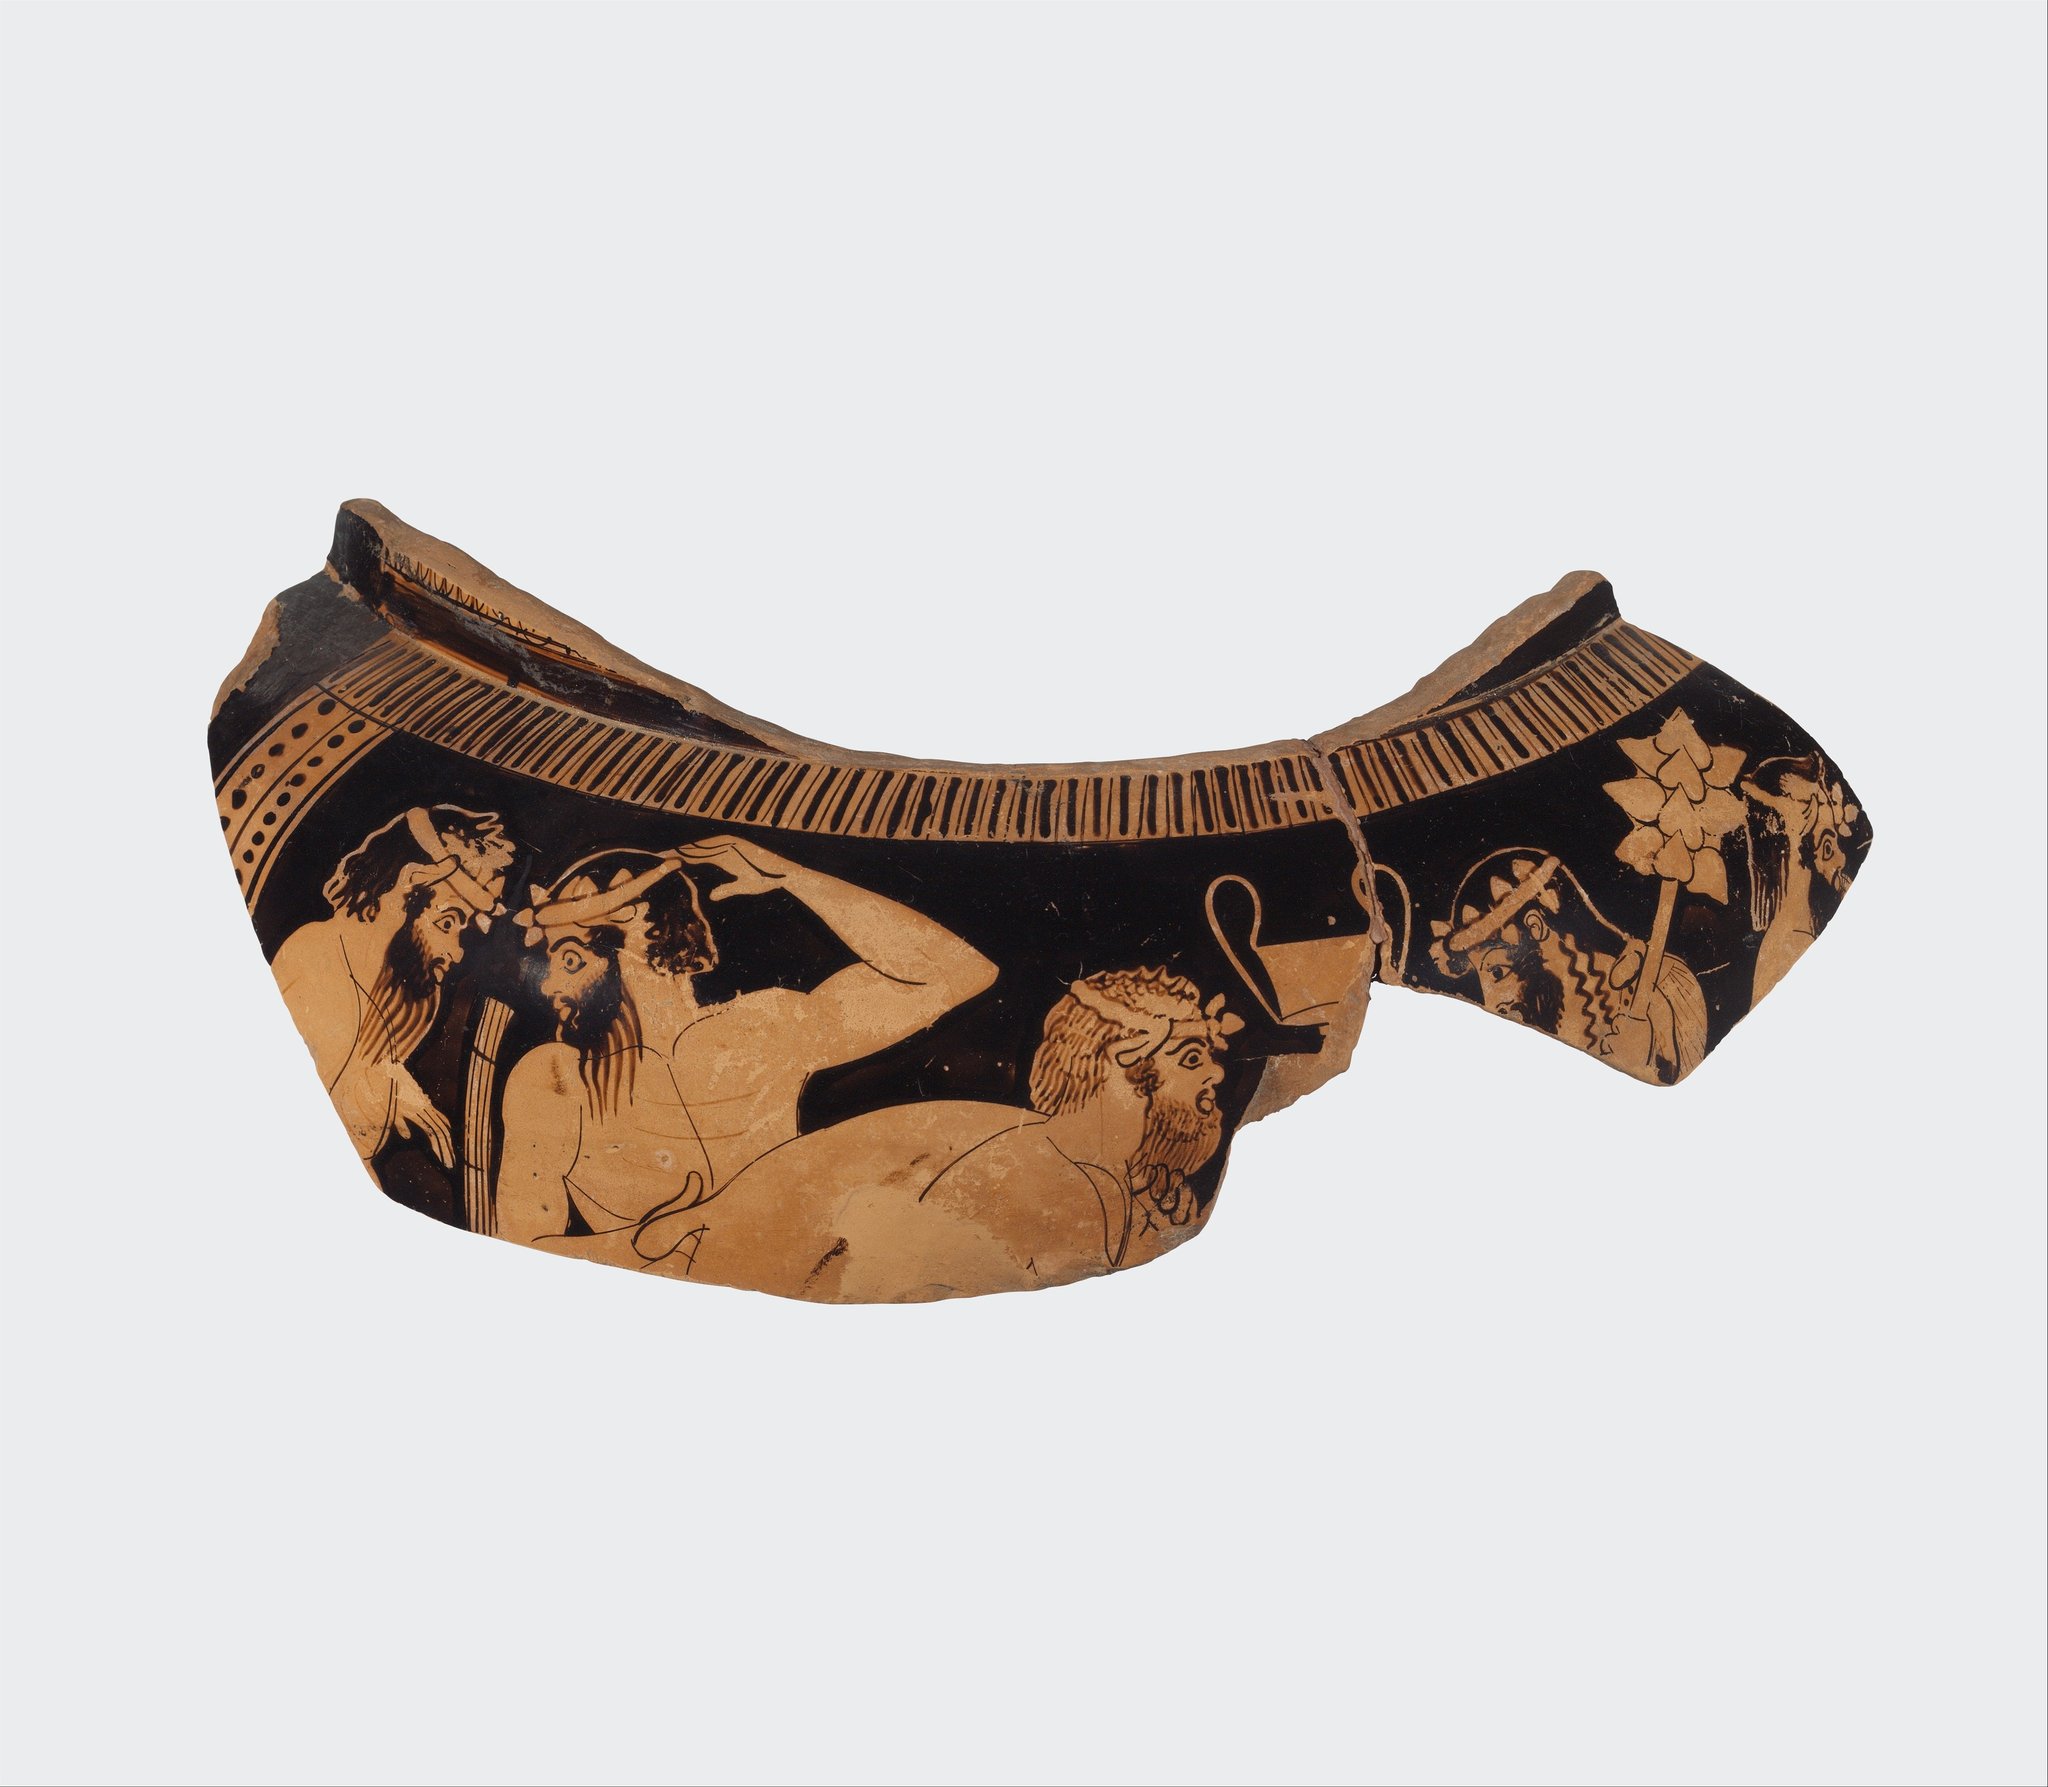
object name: column krater fragment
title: Fragment of a terracotta column-krater (mixing bowl for wine and water)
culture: greek, attic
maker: florence painter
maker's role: artist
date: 460 BCE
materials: terracotta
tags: satyrs